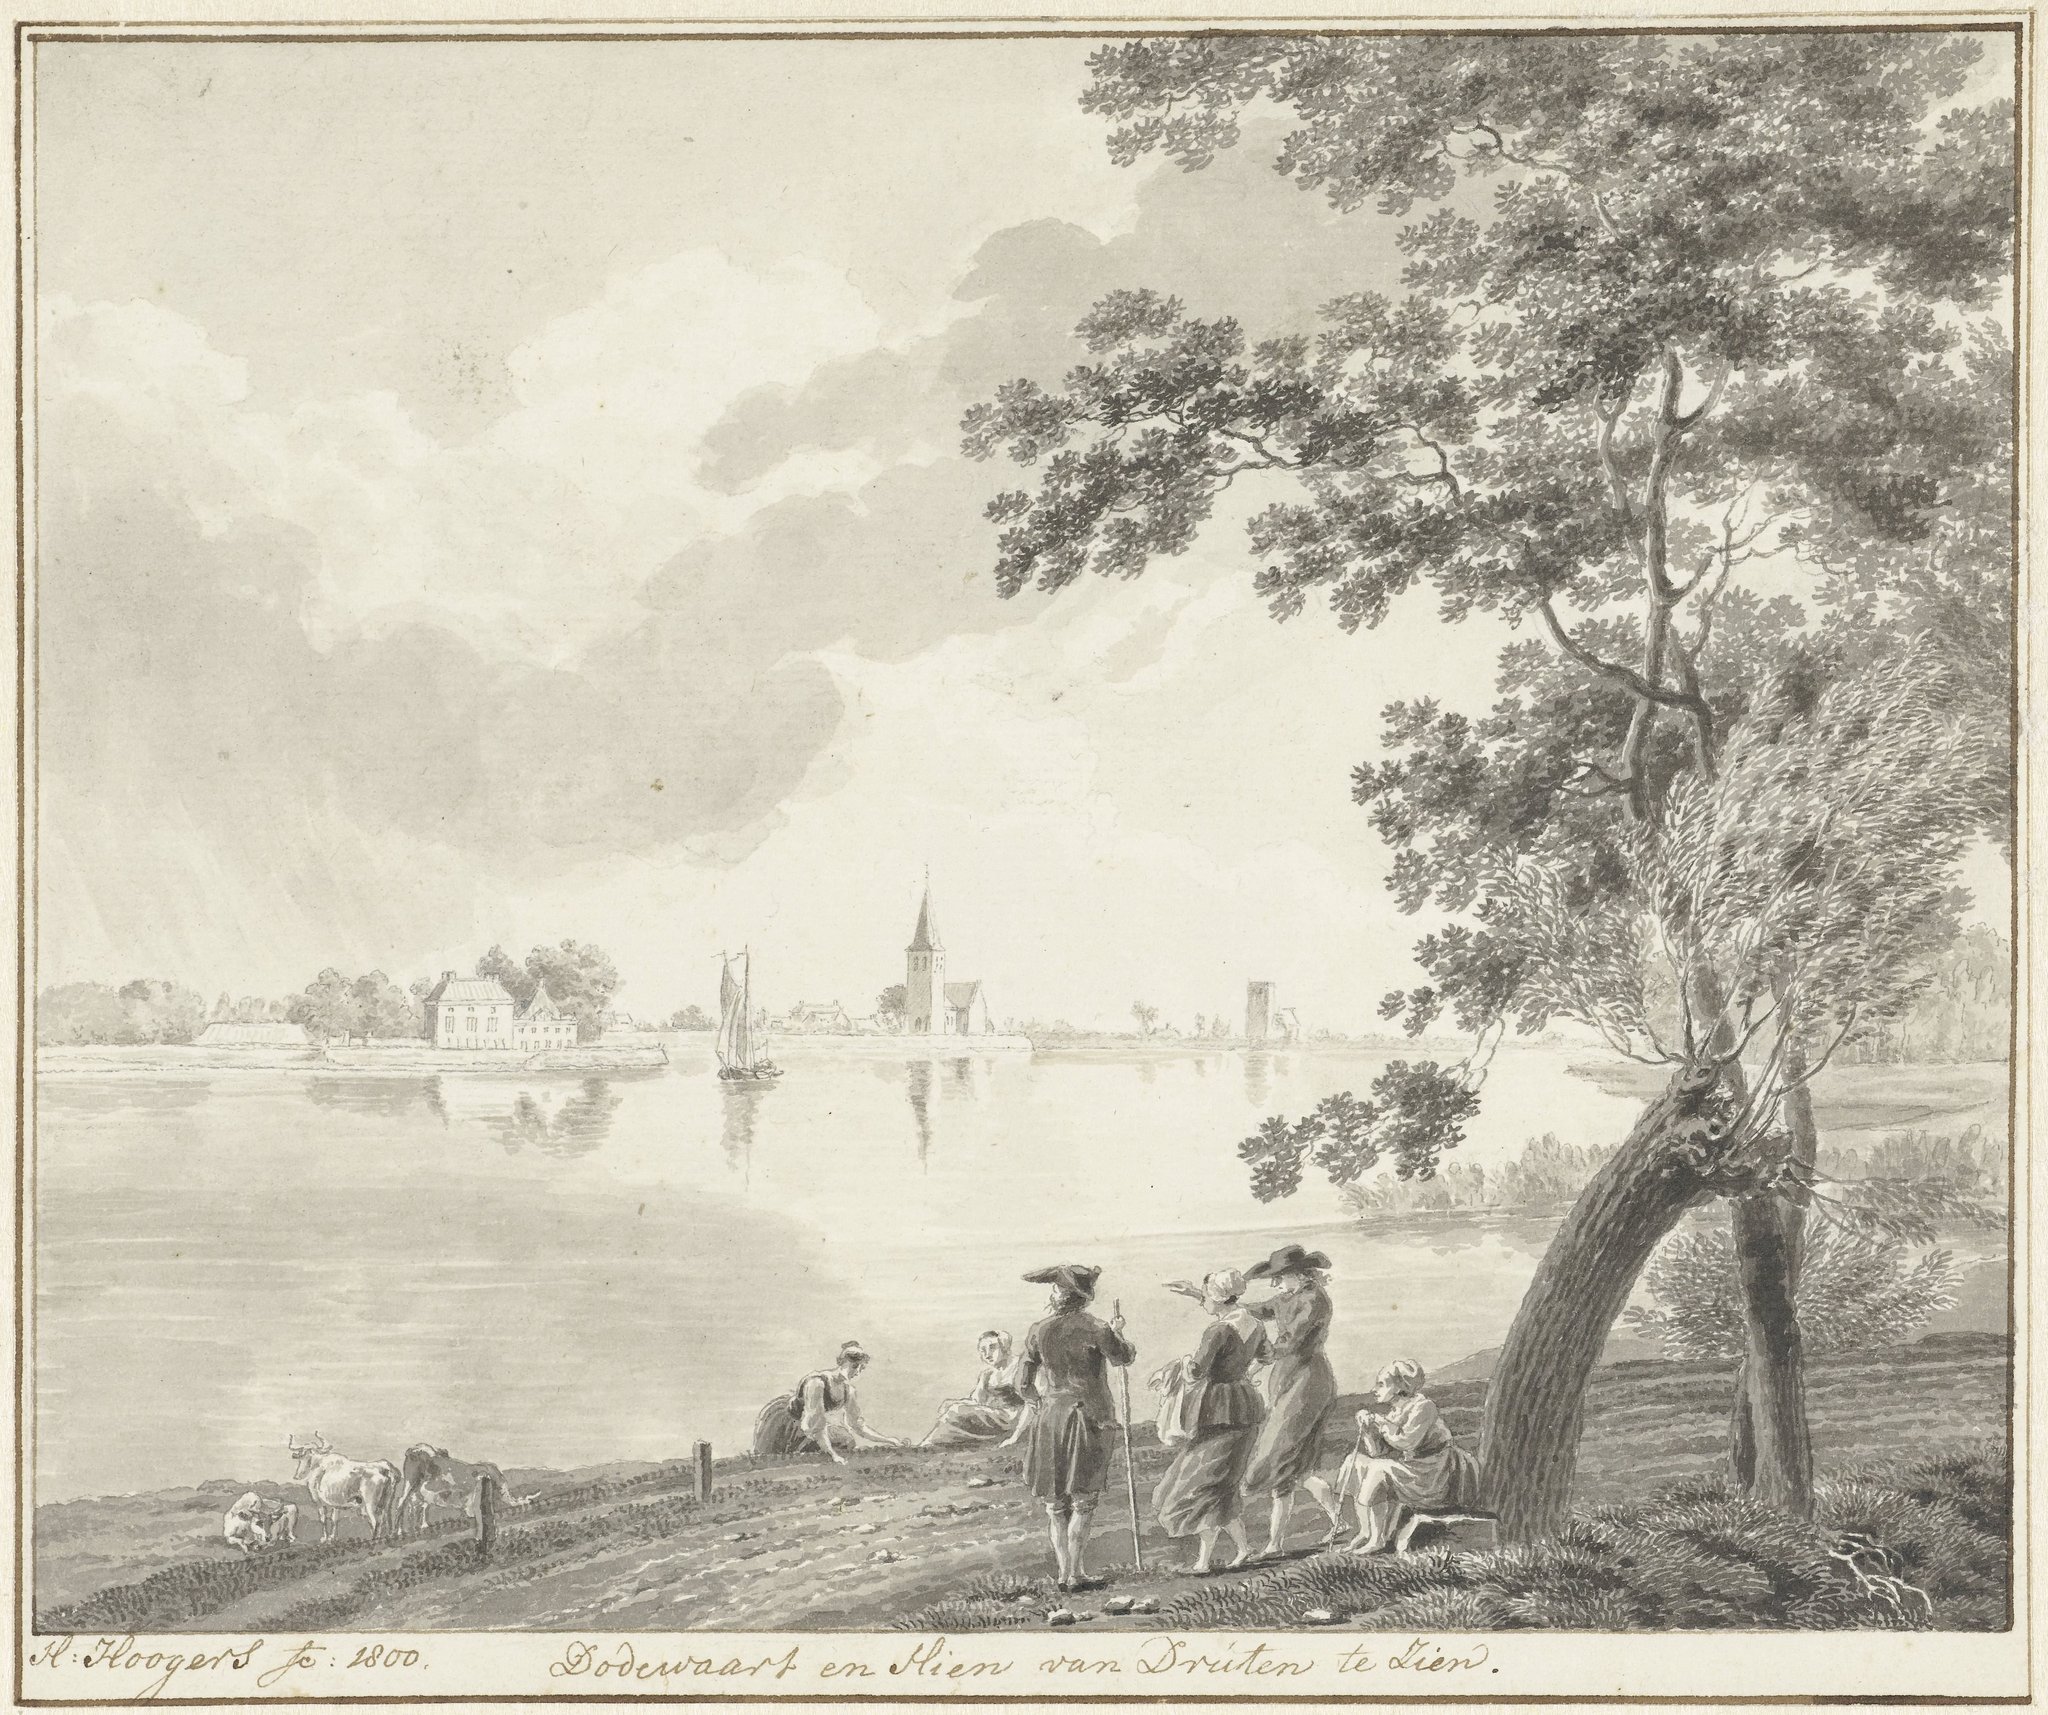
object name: drawing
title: Gezicht op Dodewaard en Hien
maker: hendrik hoogers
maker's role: draughtsman, mayor, print maker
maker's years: 1747-1814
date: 1800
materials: ink, paper, pencil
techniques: brush, pen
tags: prospect of village, silhouette of village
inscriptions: inscription: ‘Dodewaart en Hien van Druten te Zien’